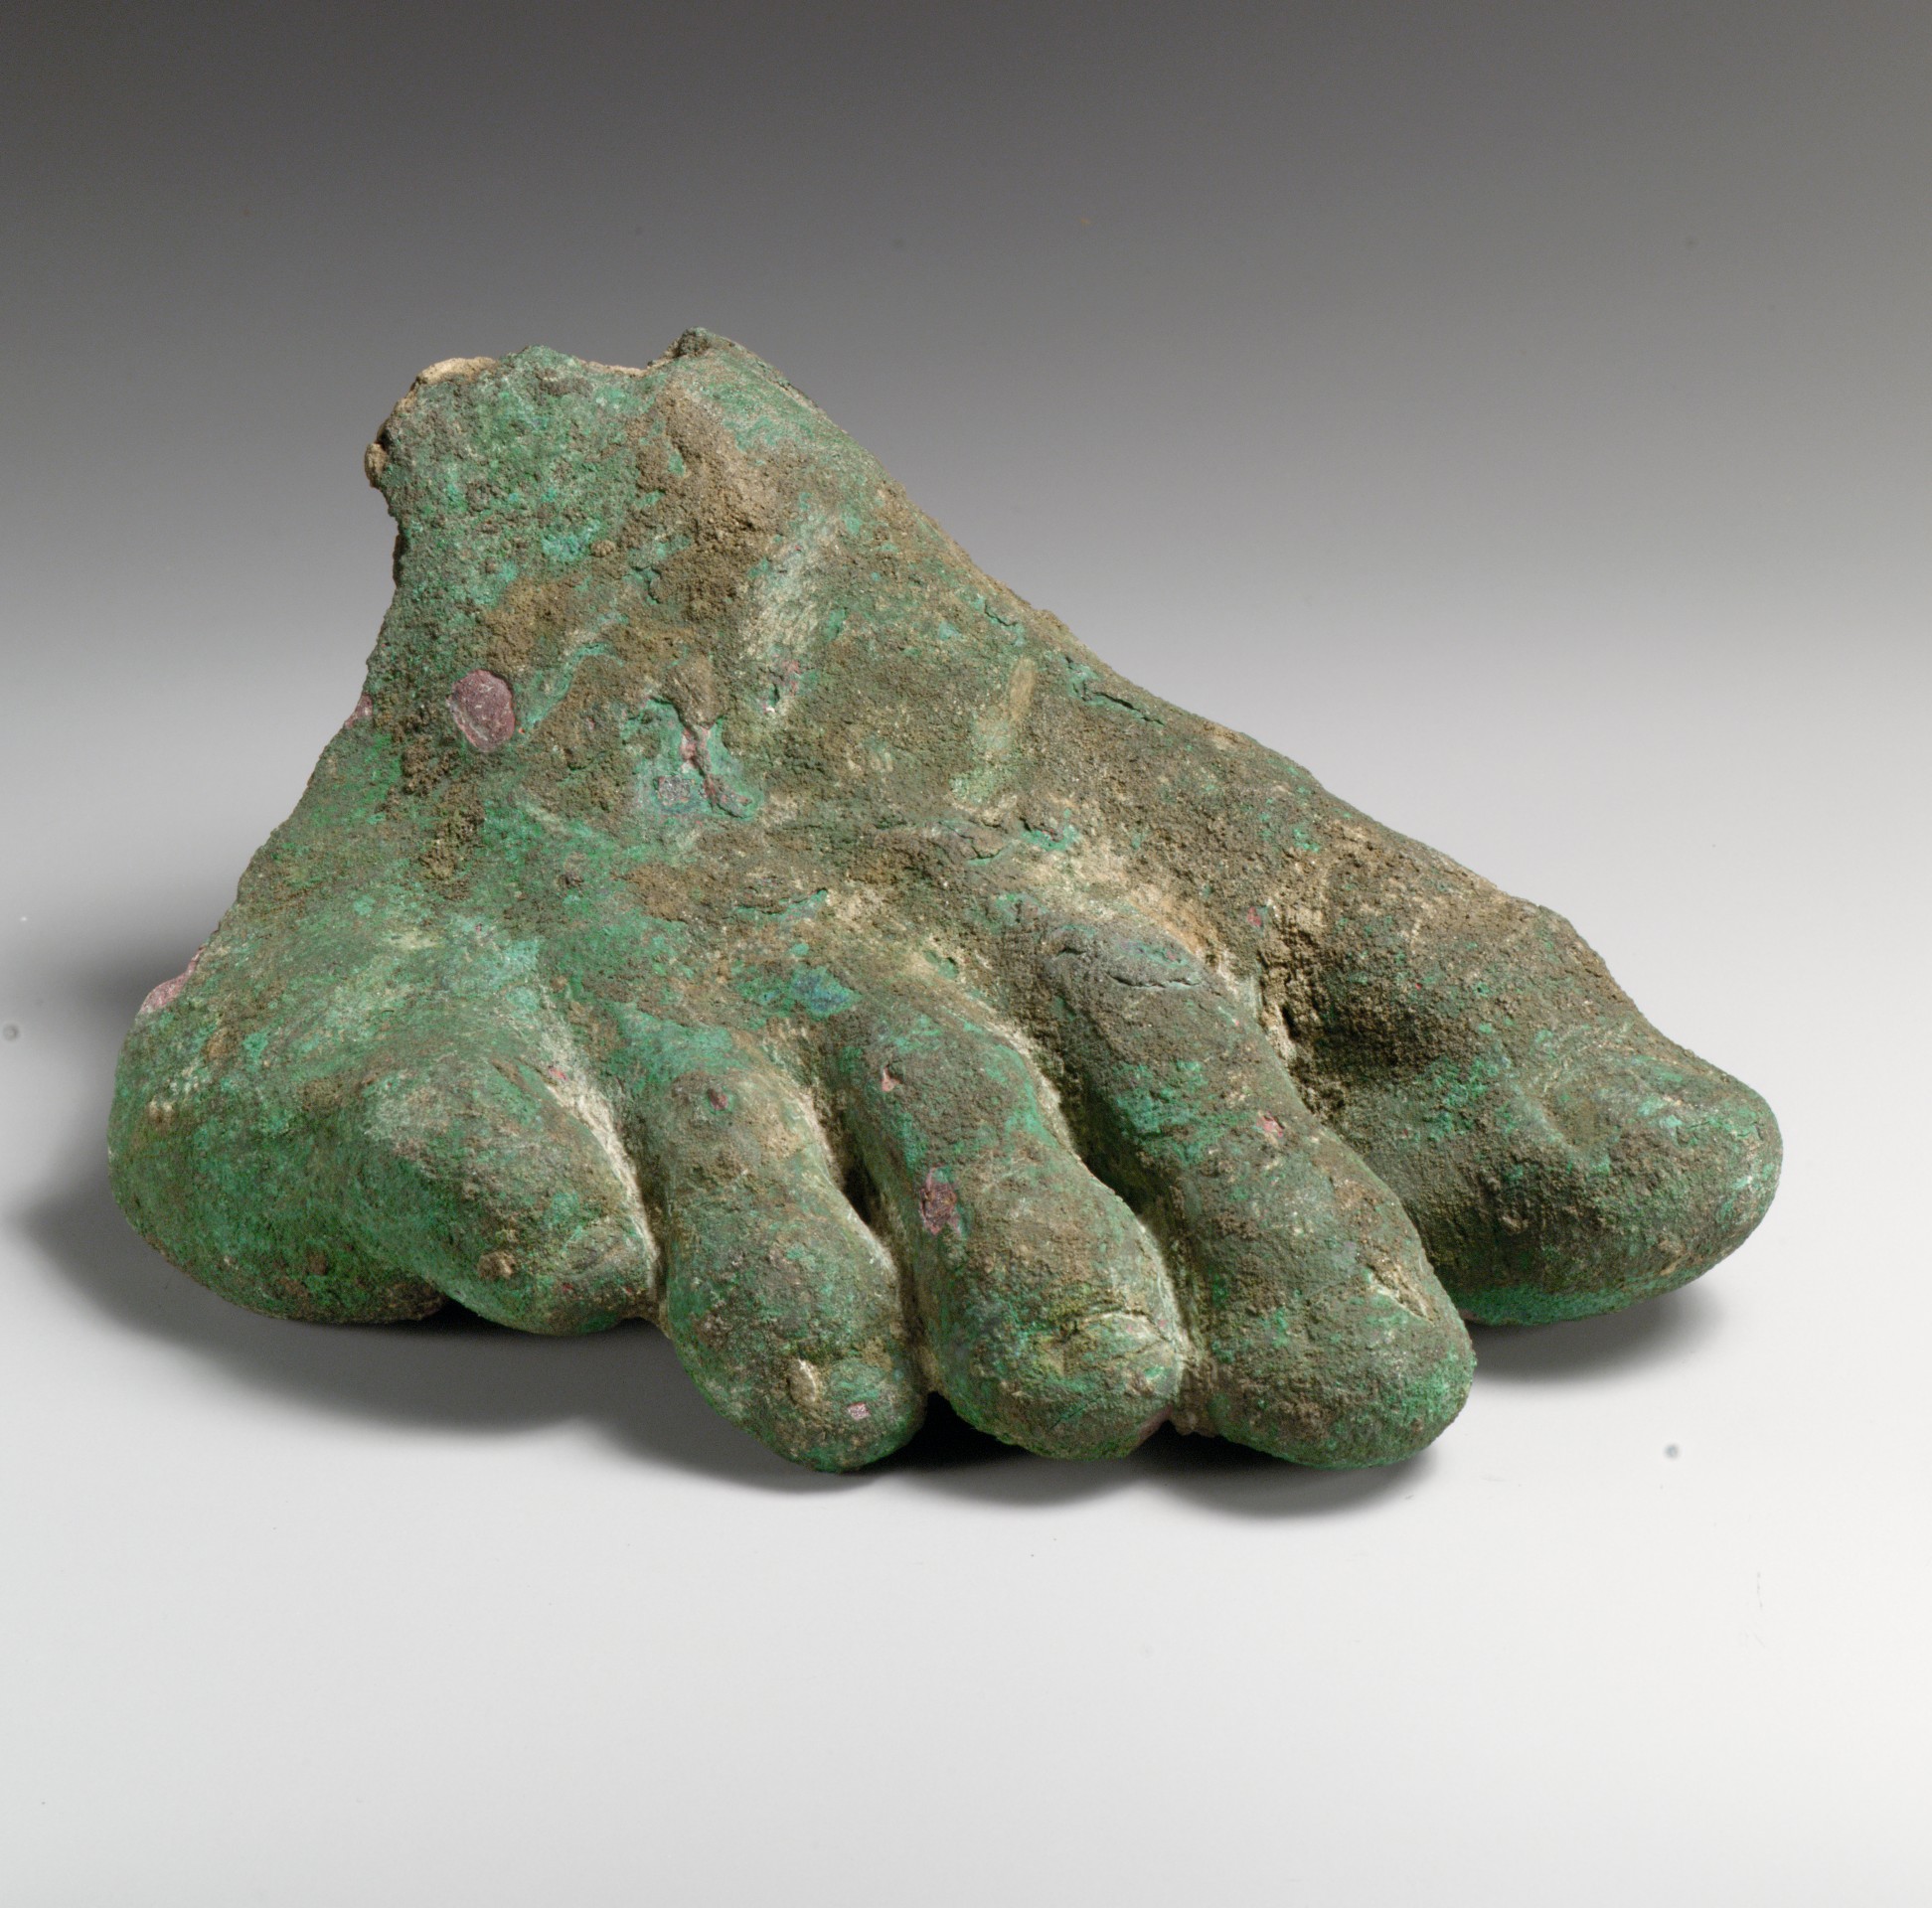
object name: foot fragment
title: Bronze toes and instep of an over-lifesized right foot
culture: roman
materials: bronze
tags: feet